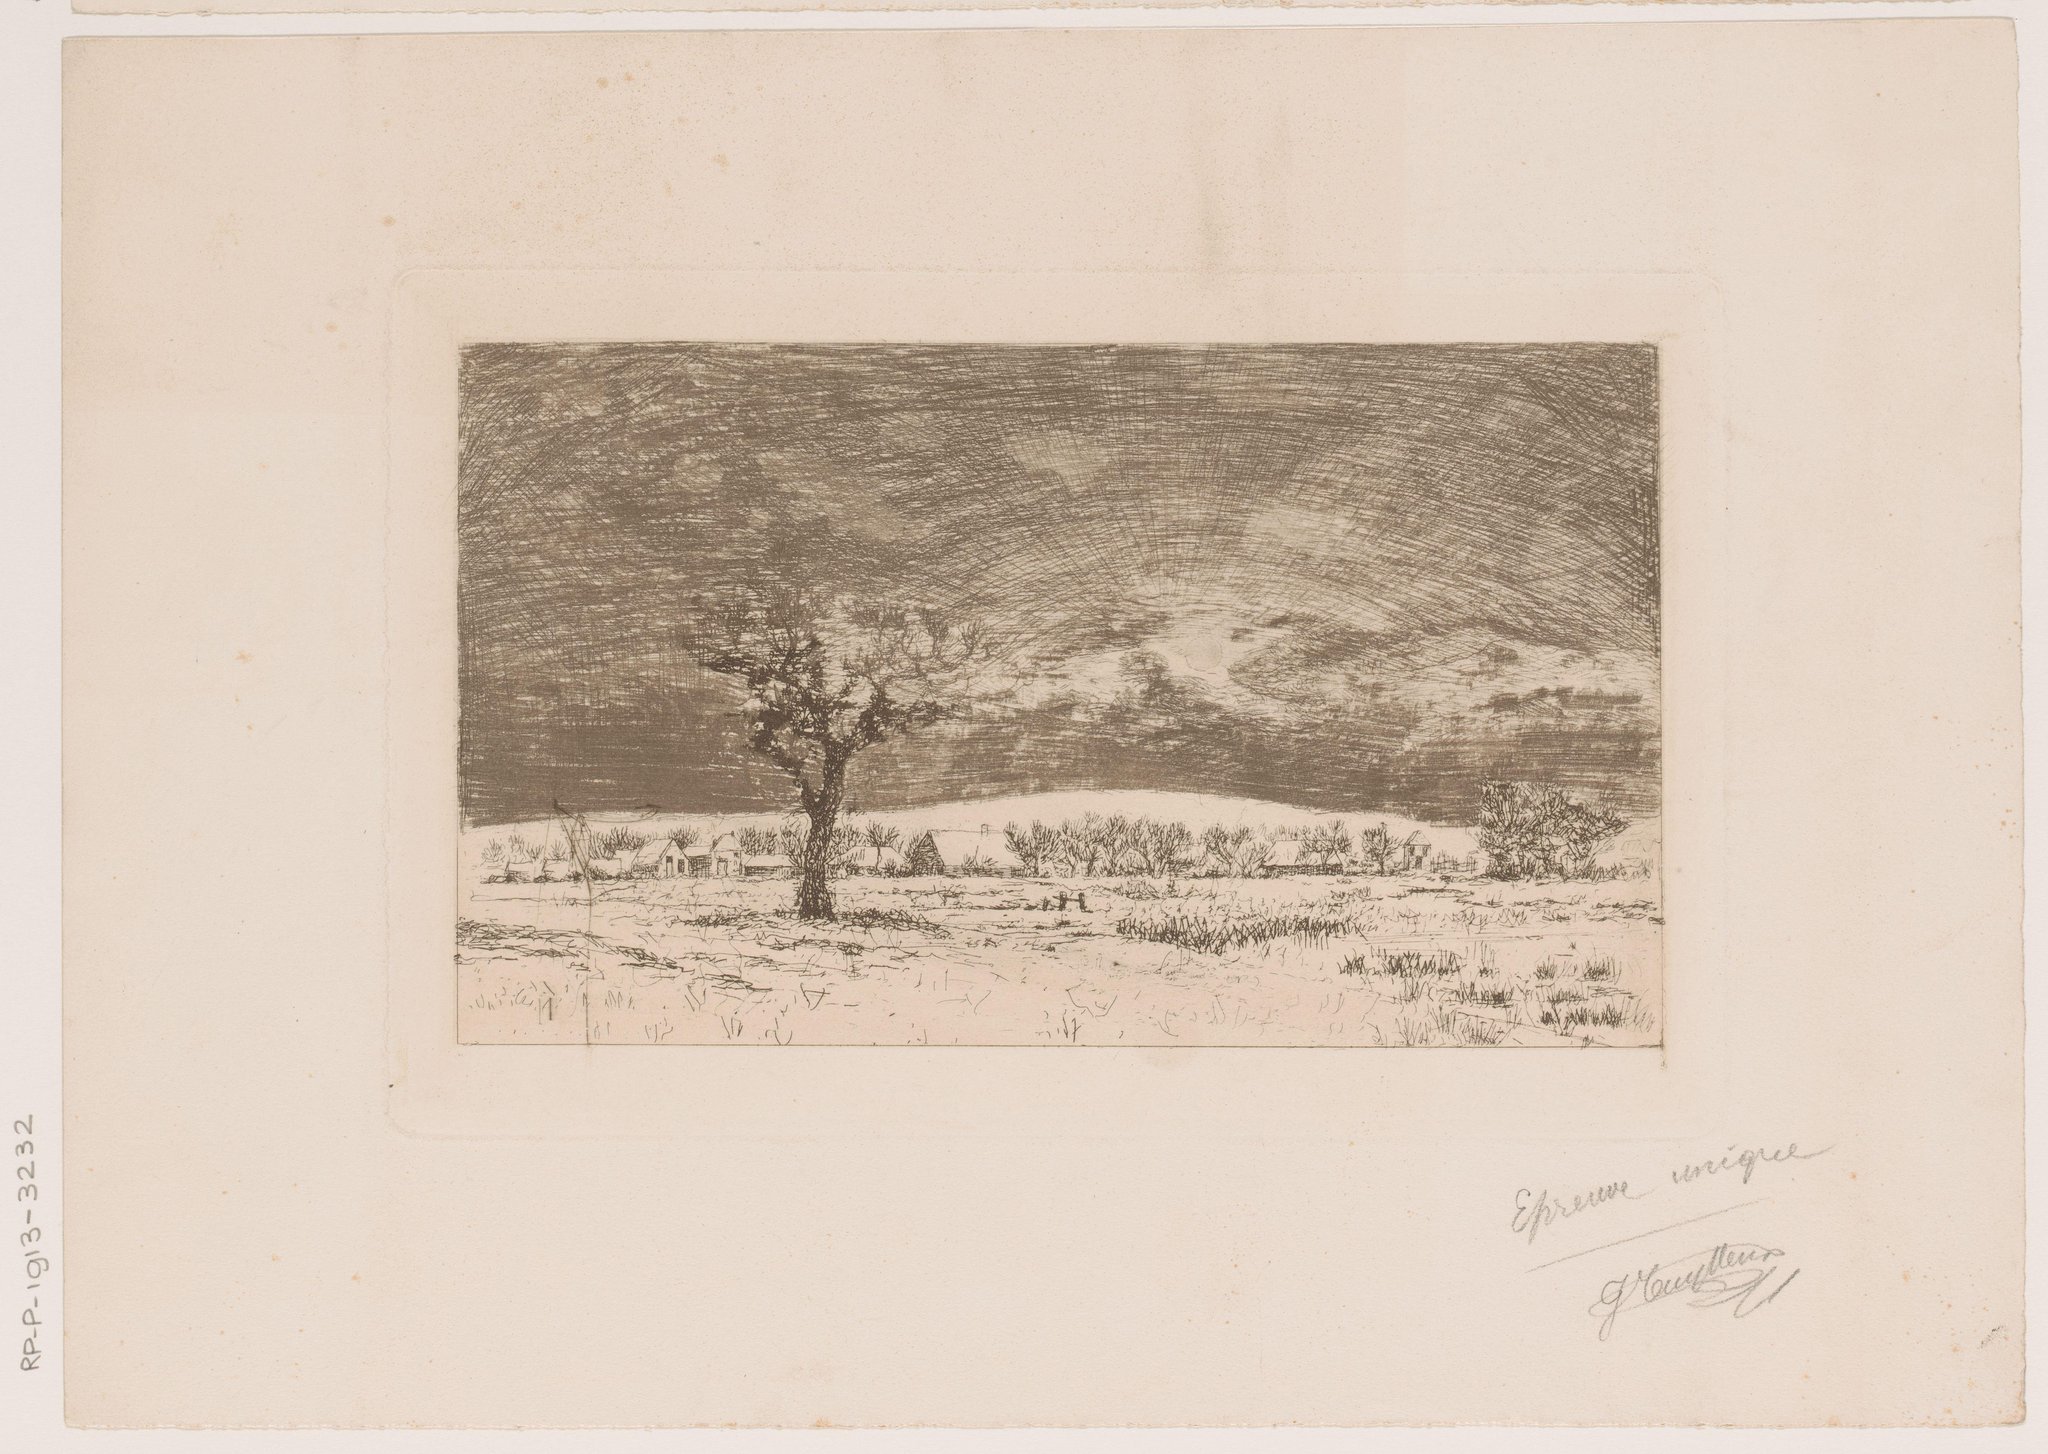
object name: print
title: Winterlandschap bij maanlicht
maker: jerôme tuyttens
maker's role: painter, print maker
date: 1850-1900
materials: paper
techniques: drypoint, etching, intaglio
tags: landscapes, moonlight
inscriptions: collector's mark: Lugt 2228, annotation: ‘Epreuve unique’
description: Sterfdatum van de prentmaker is onbekend. Daarom is voor de bepaling van de rechten van dit object gebruik gemaakt van de verwervingsdatum Rijksmuseum Amsterdam.